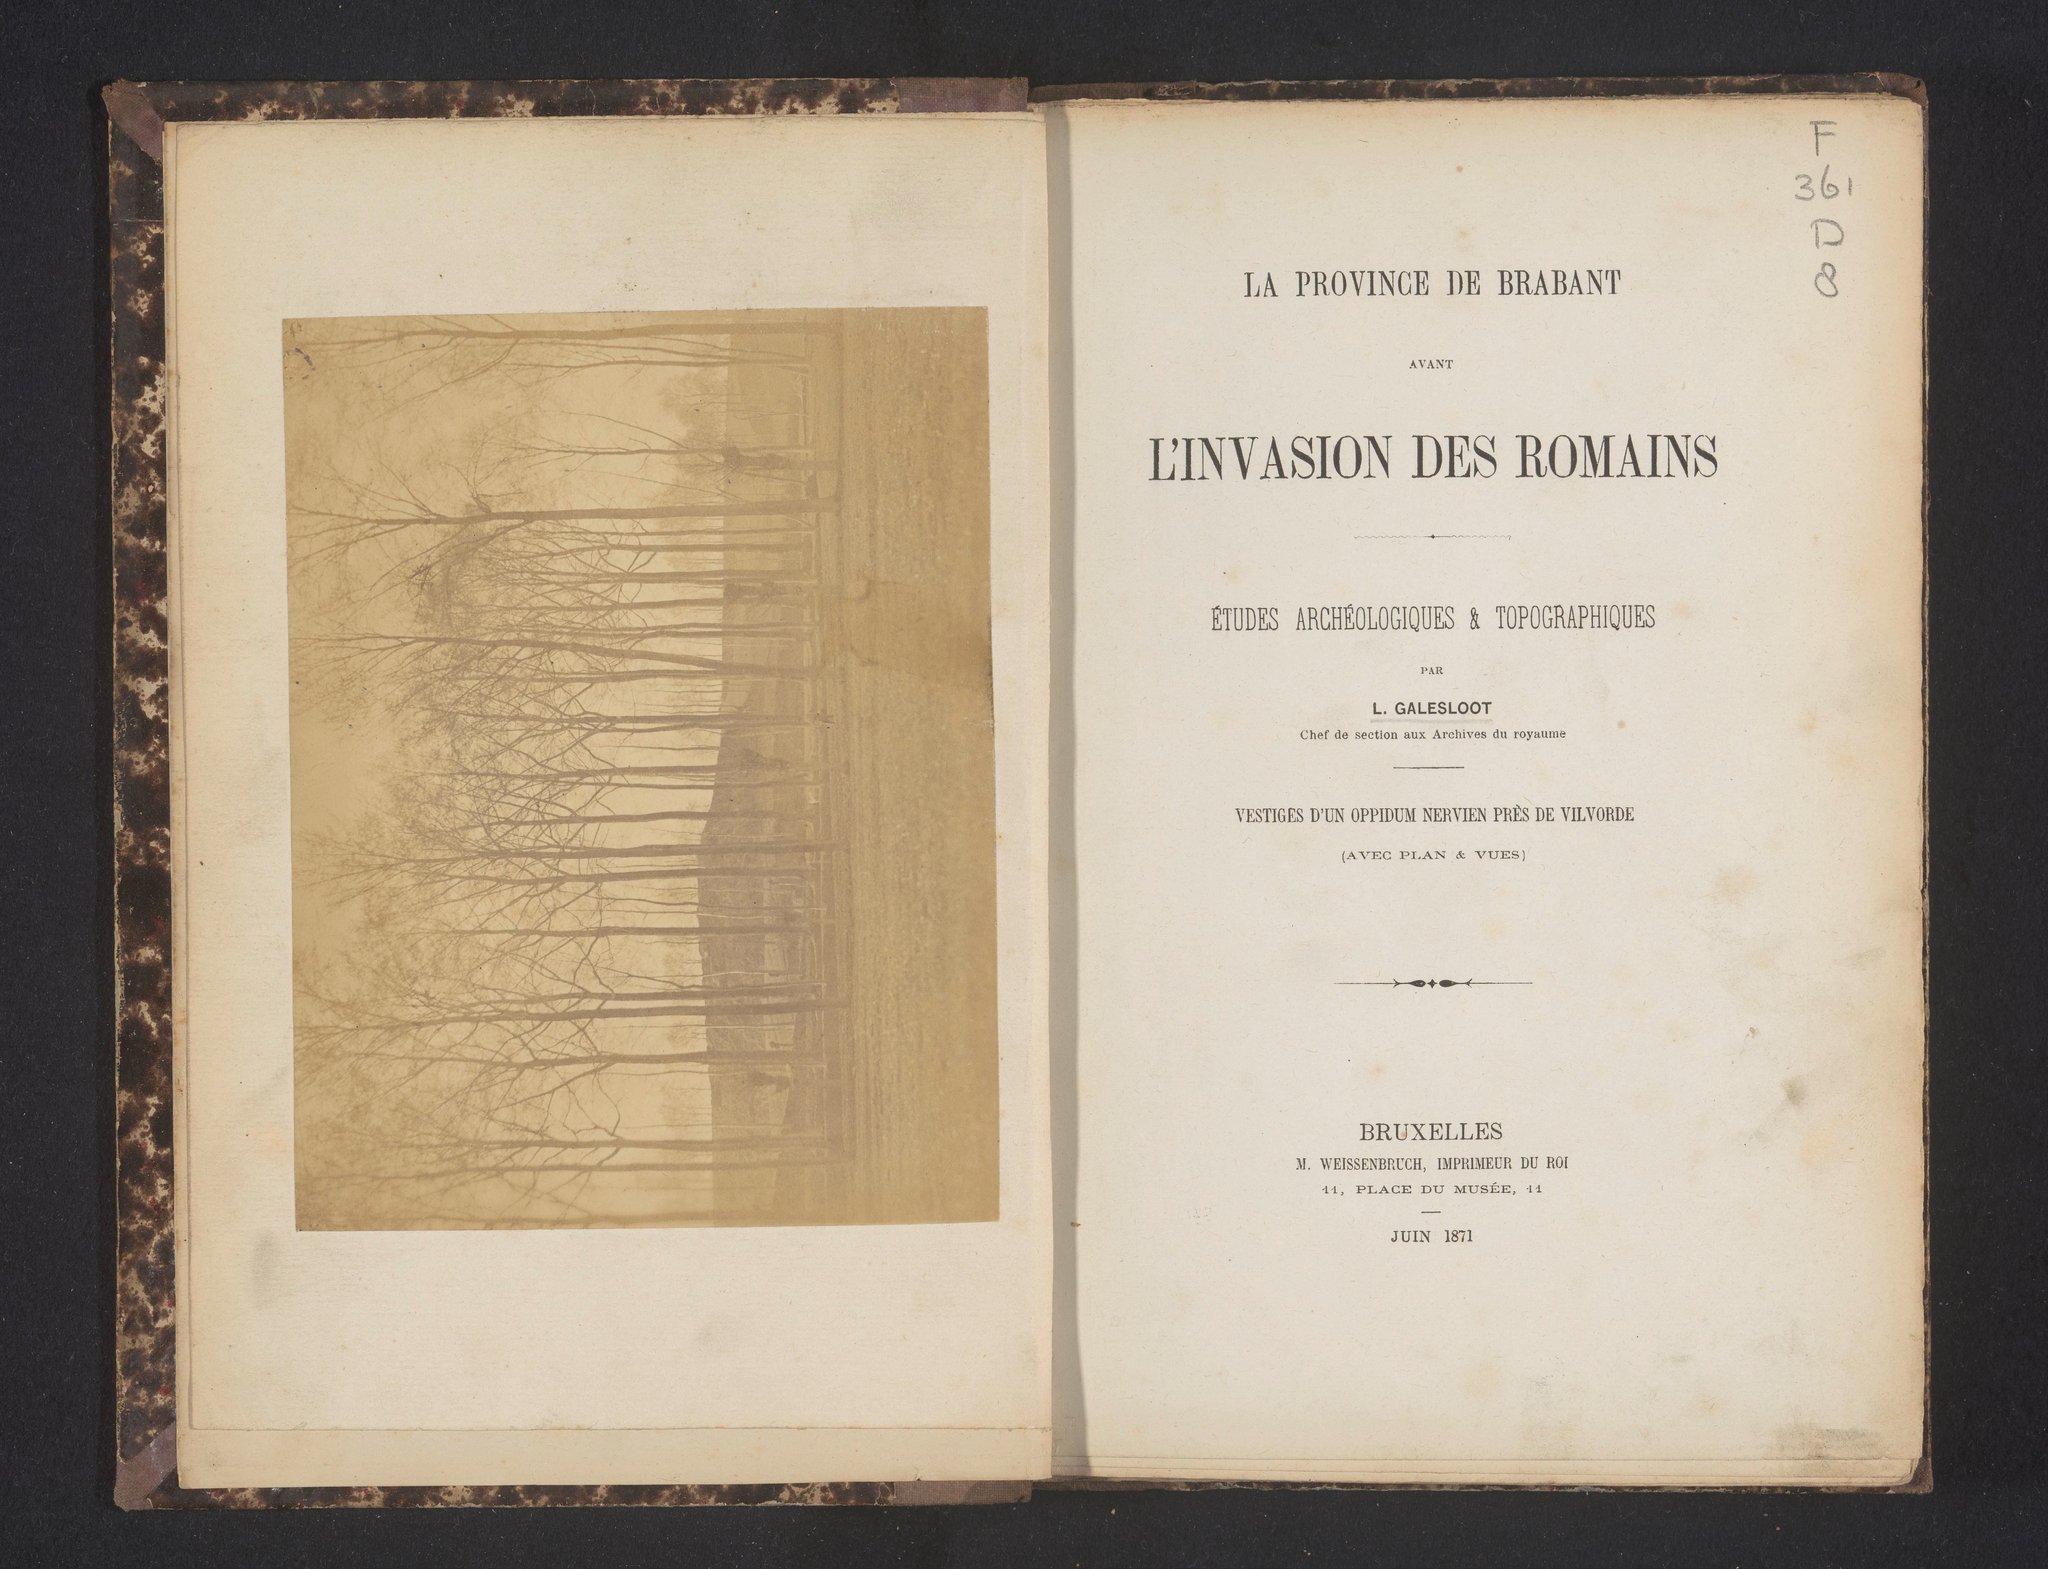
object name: photograph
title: Landschap met bomen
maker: Anonymous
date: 1869-1871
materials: photographic support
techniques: albumen print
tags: landscapes